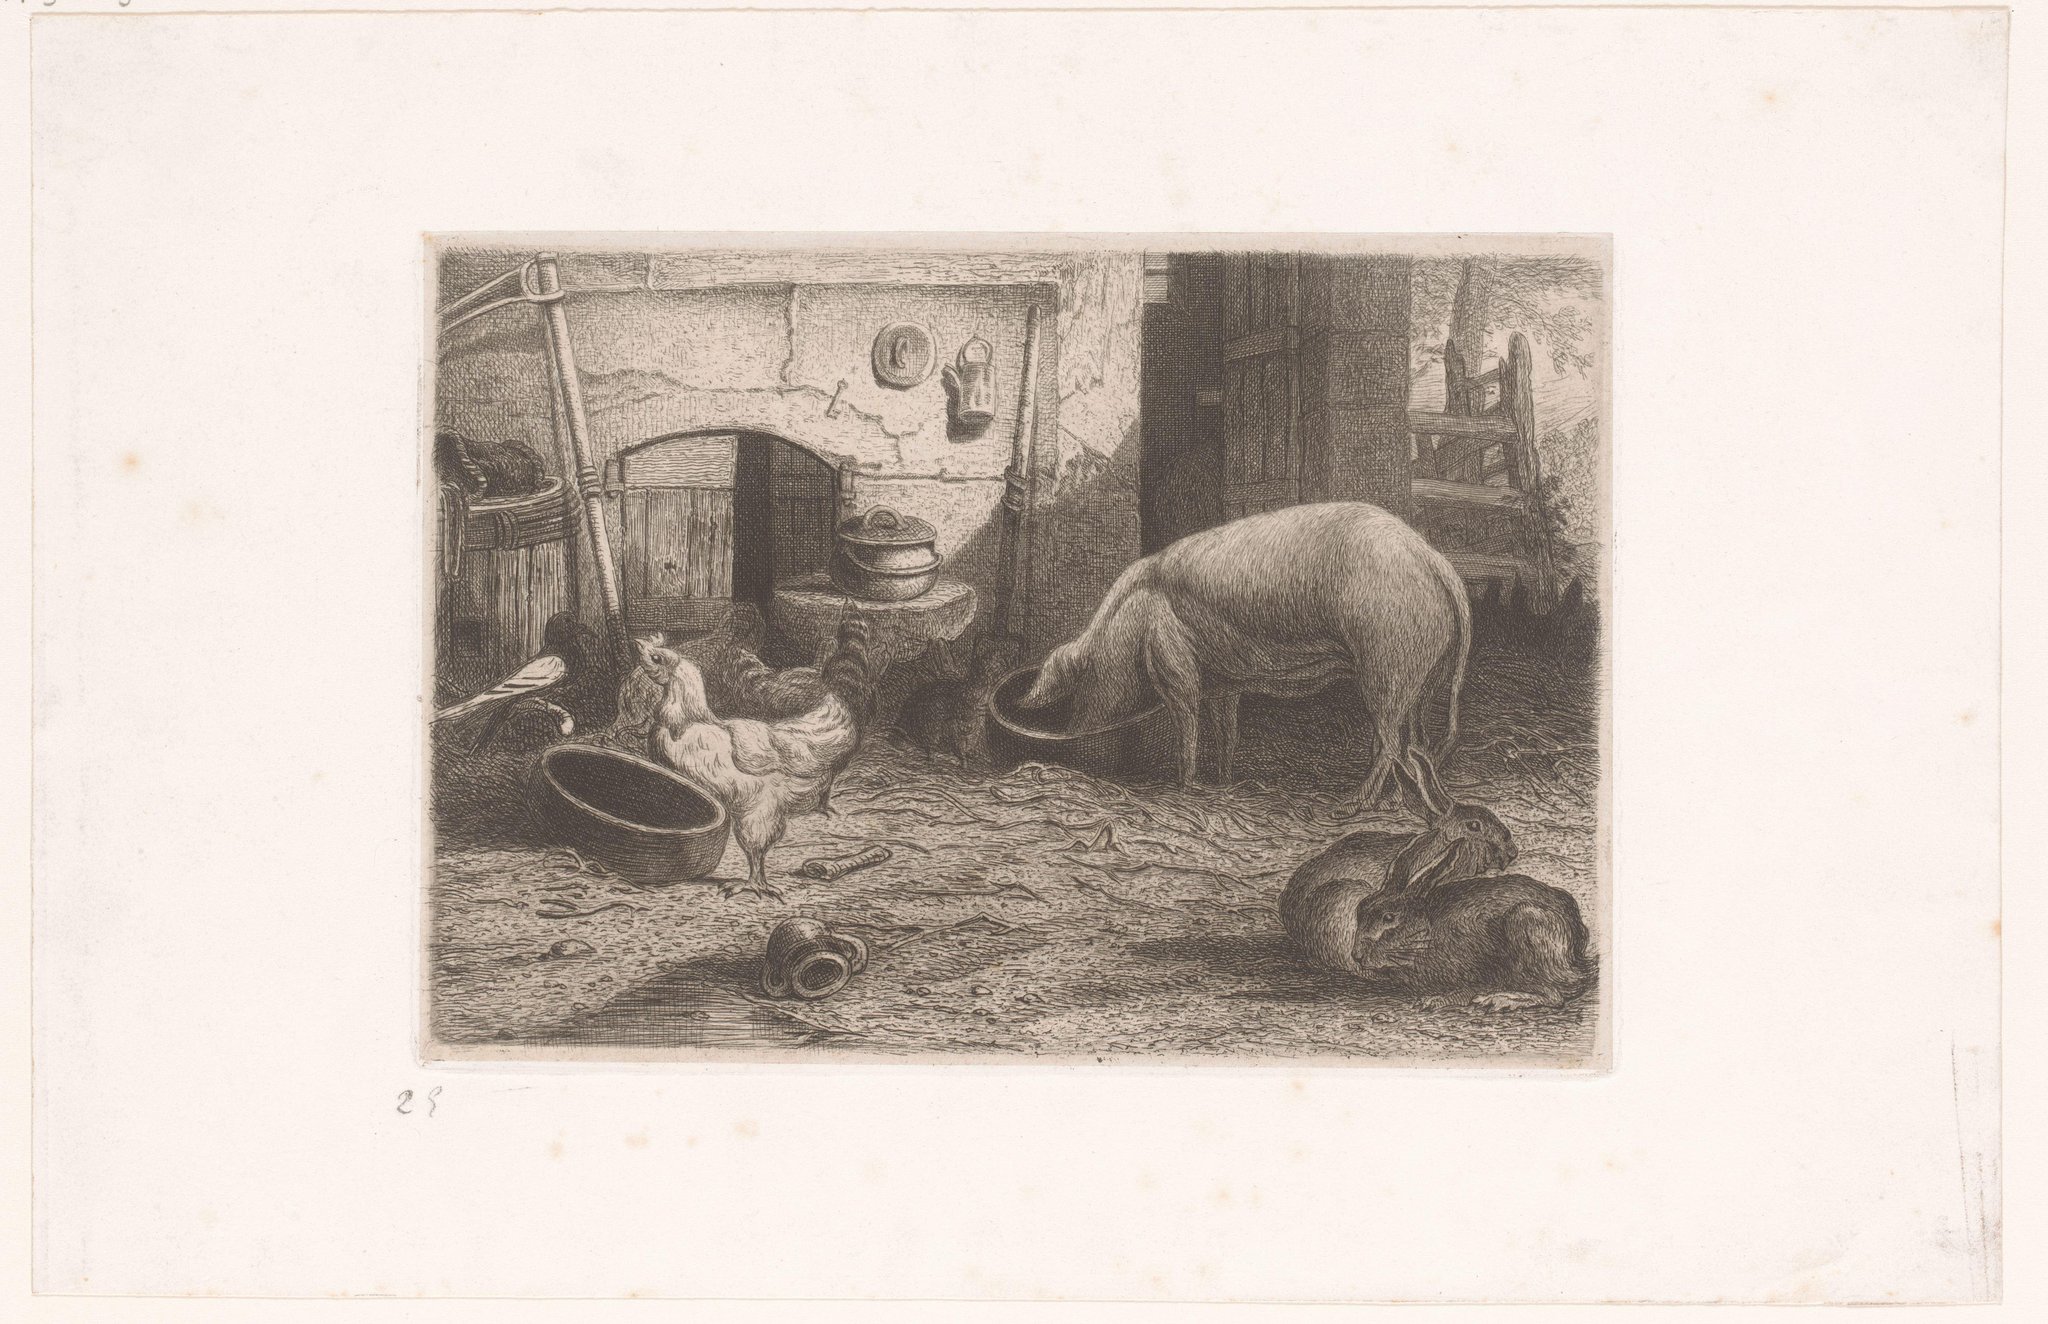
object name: print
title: Varken, kippen en konijnen bij een schuur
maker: auguste numans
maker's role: print maker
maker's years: 1823-1883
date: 1833-1879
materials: paper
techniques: etching, intaglio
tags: barn, pig, fowl (cock, hen, chicken, etc.), rodents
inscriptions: collector's mark: Lugt 2228